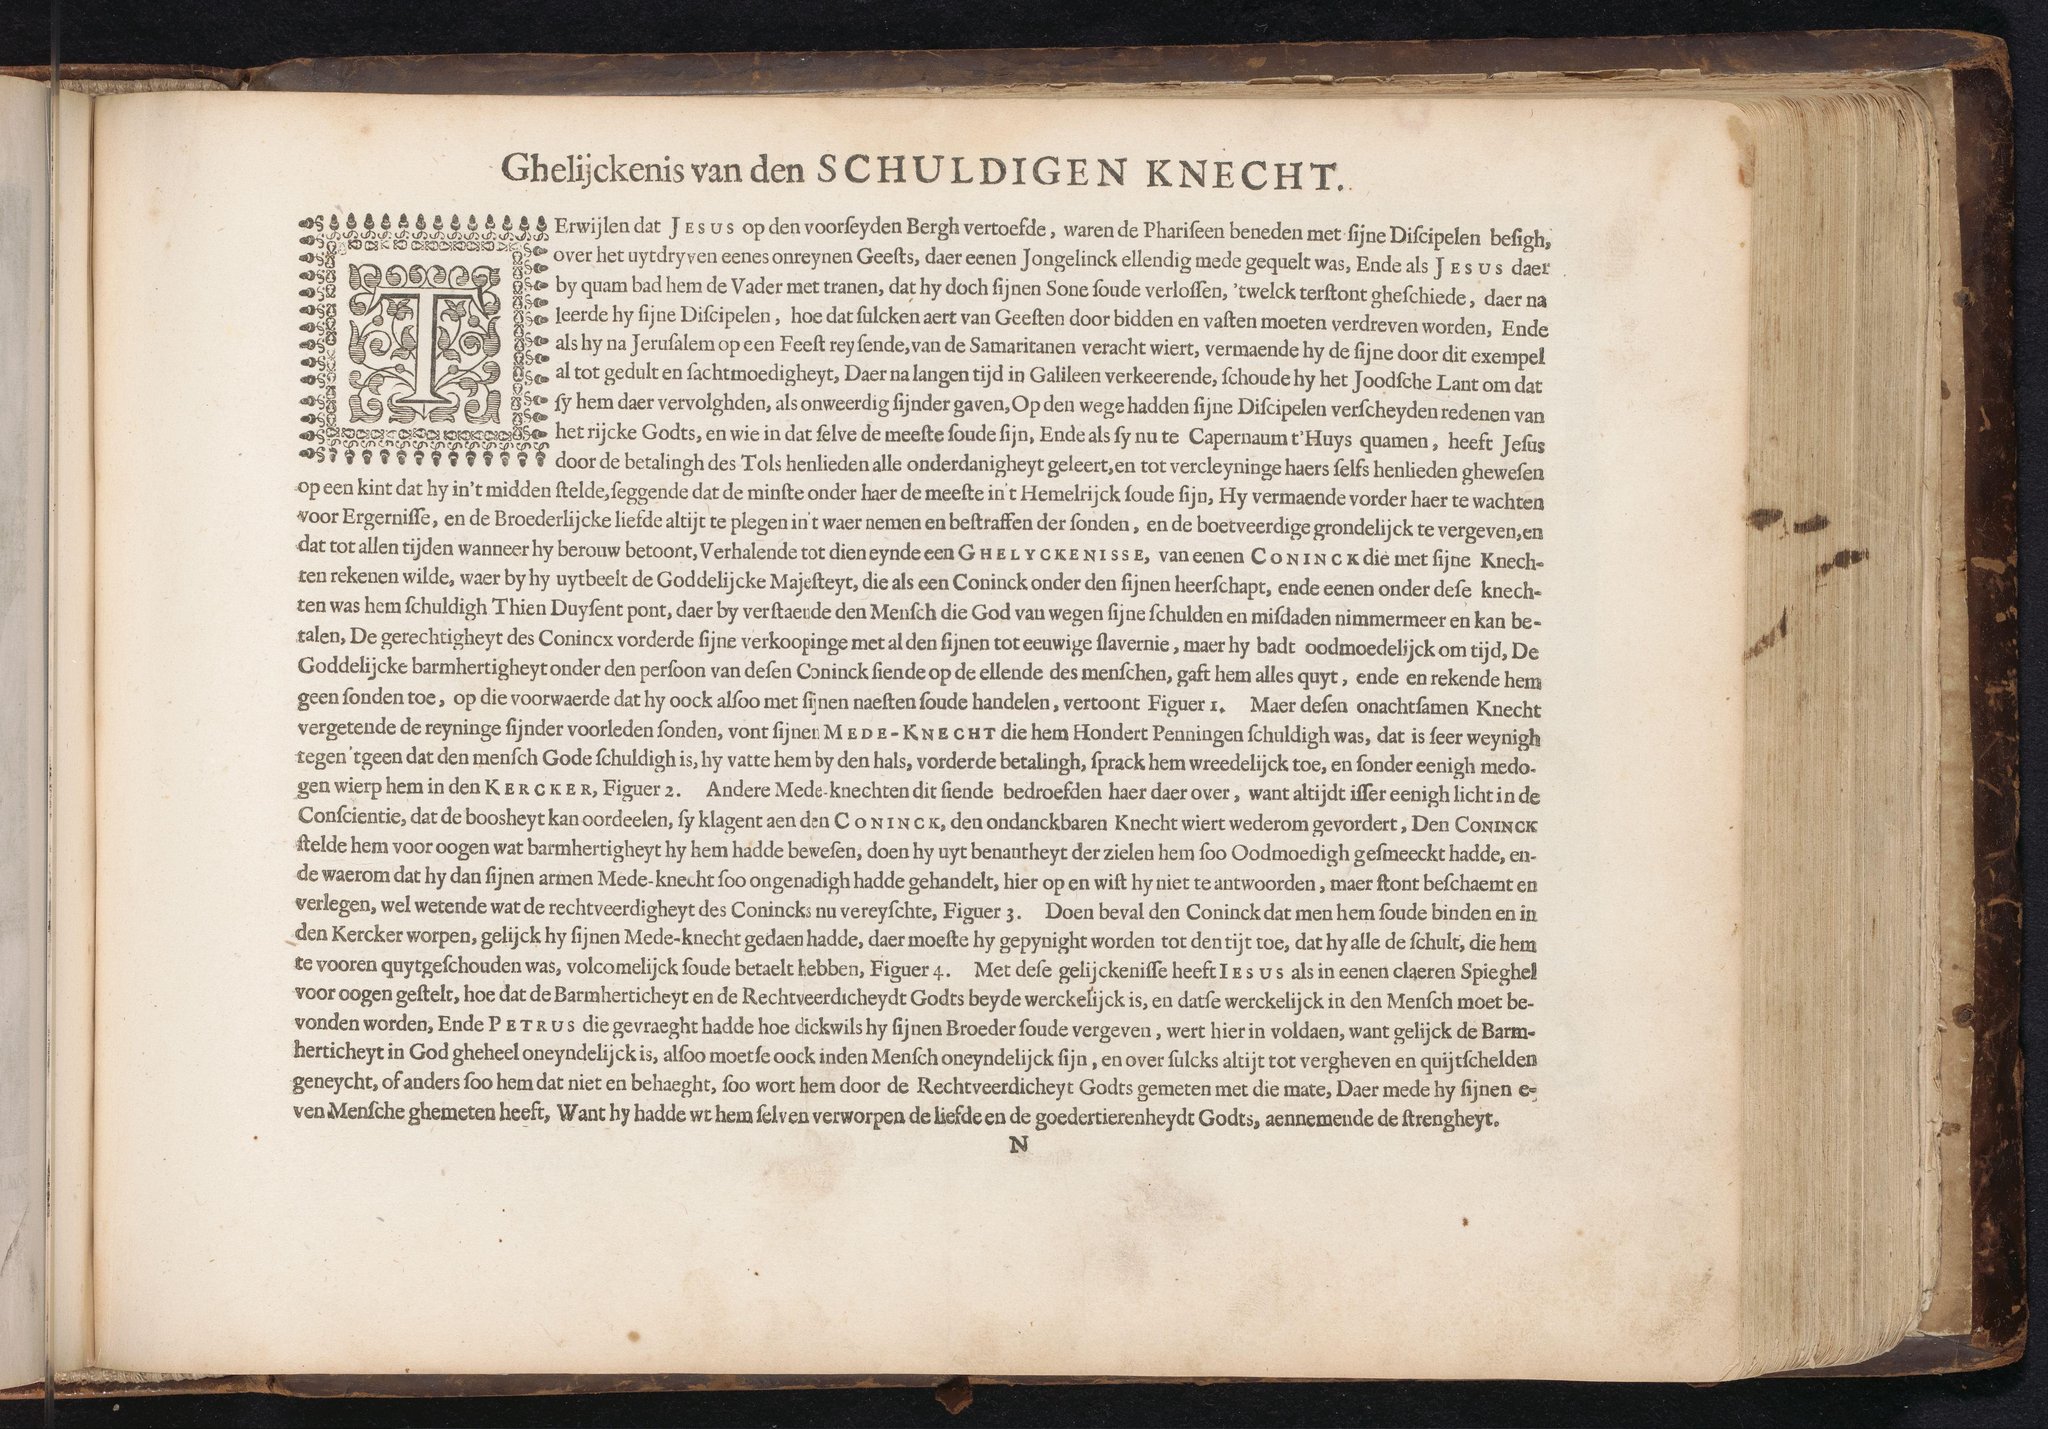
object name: album leaf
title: Den Grooten Figuer-Bibel (...)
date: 1646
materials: paper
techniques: letterpress printing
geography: alkmaar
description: Tekstblad bij een serie prenten over de gelijkenis van de onbarmhartige dienaar. Linksboven initiaal T. Dit blad maakt deel uit van een album.